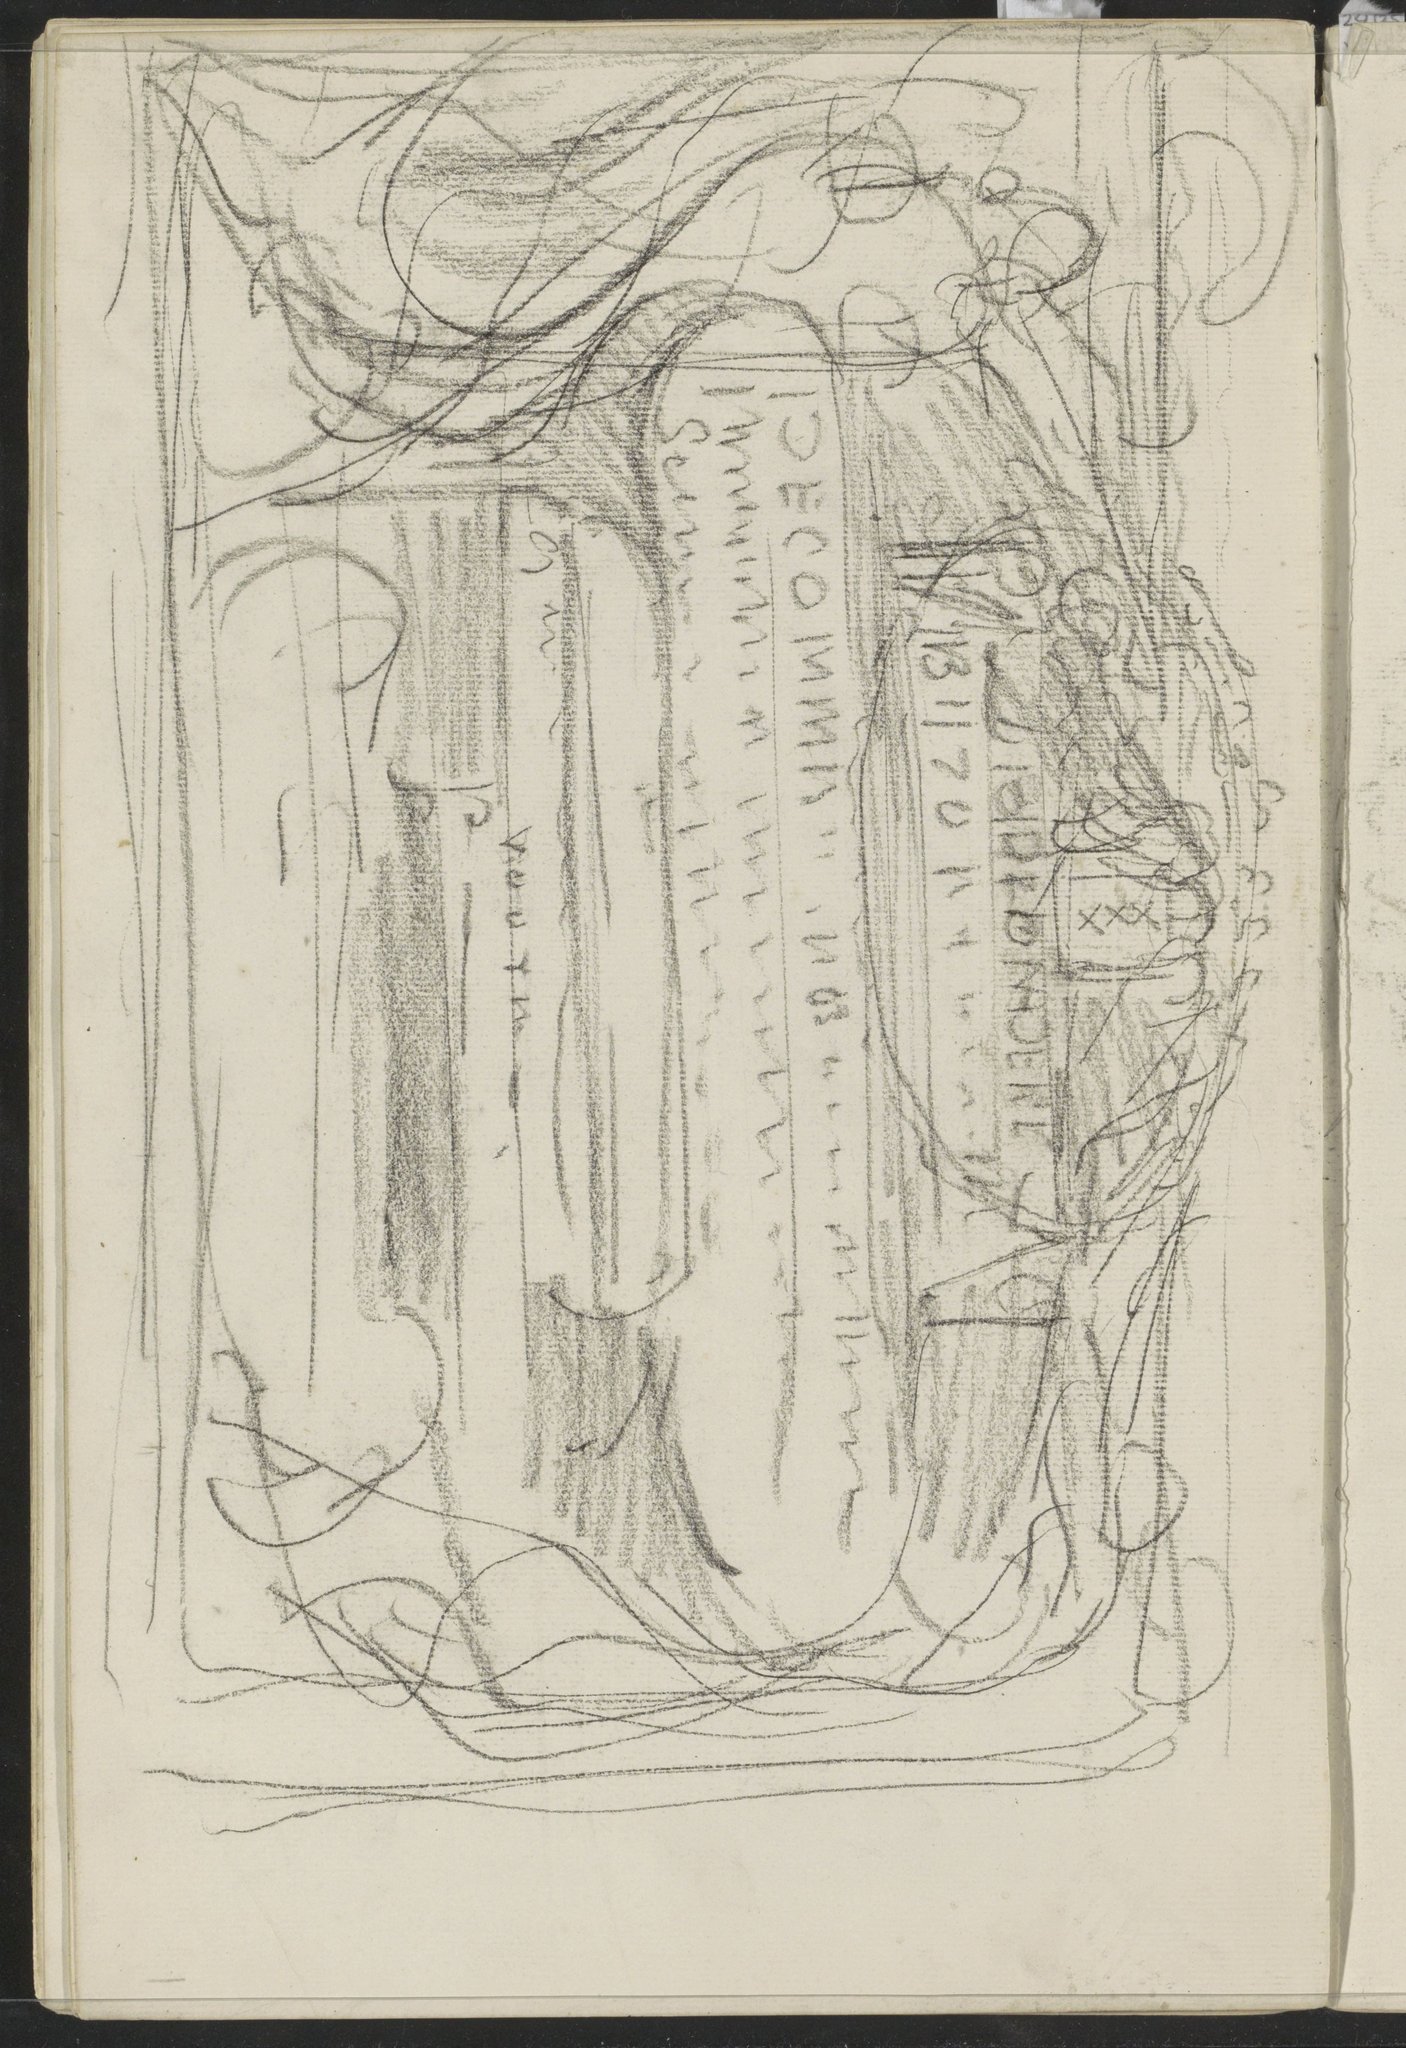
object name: sketchbook leaf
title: Ontwerp voor drukwerk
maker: carel adolph lion cachet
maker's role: draughtsman, print maker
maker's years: 1864-1945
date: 1897-1898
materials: chalk, paper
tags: printed matter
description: Blad 23 verso uit een schetsboek met 29 bladen.